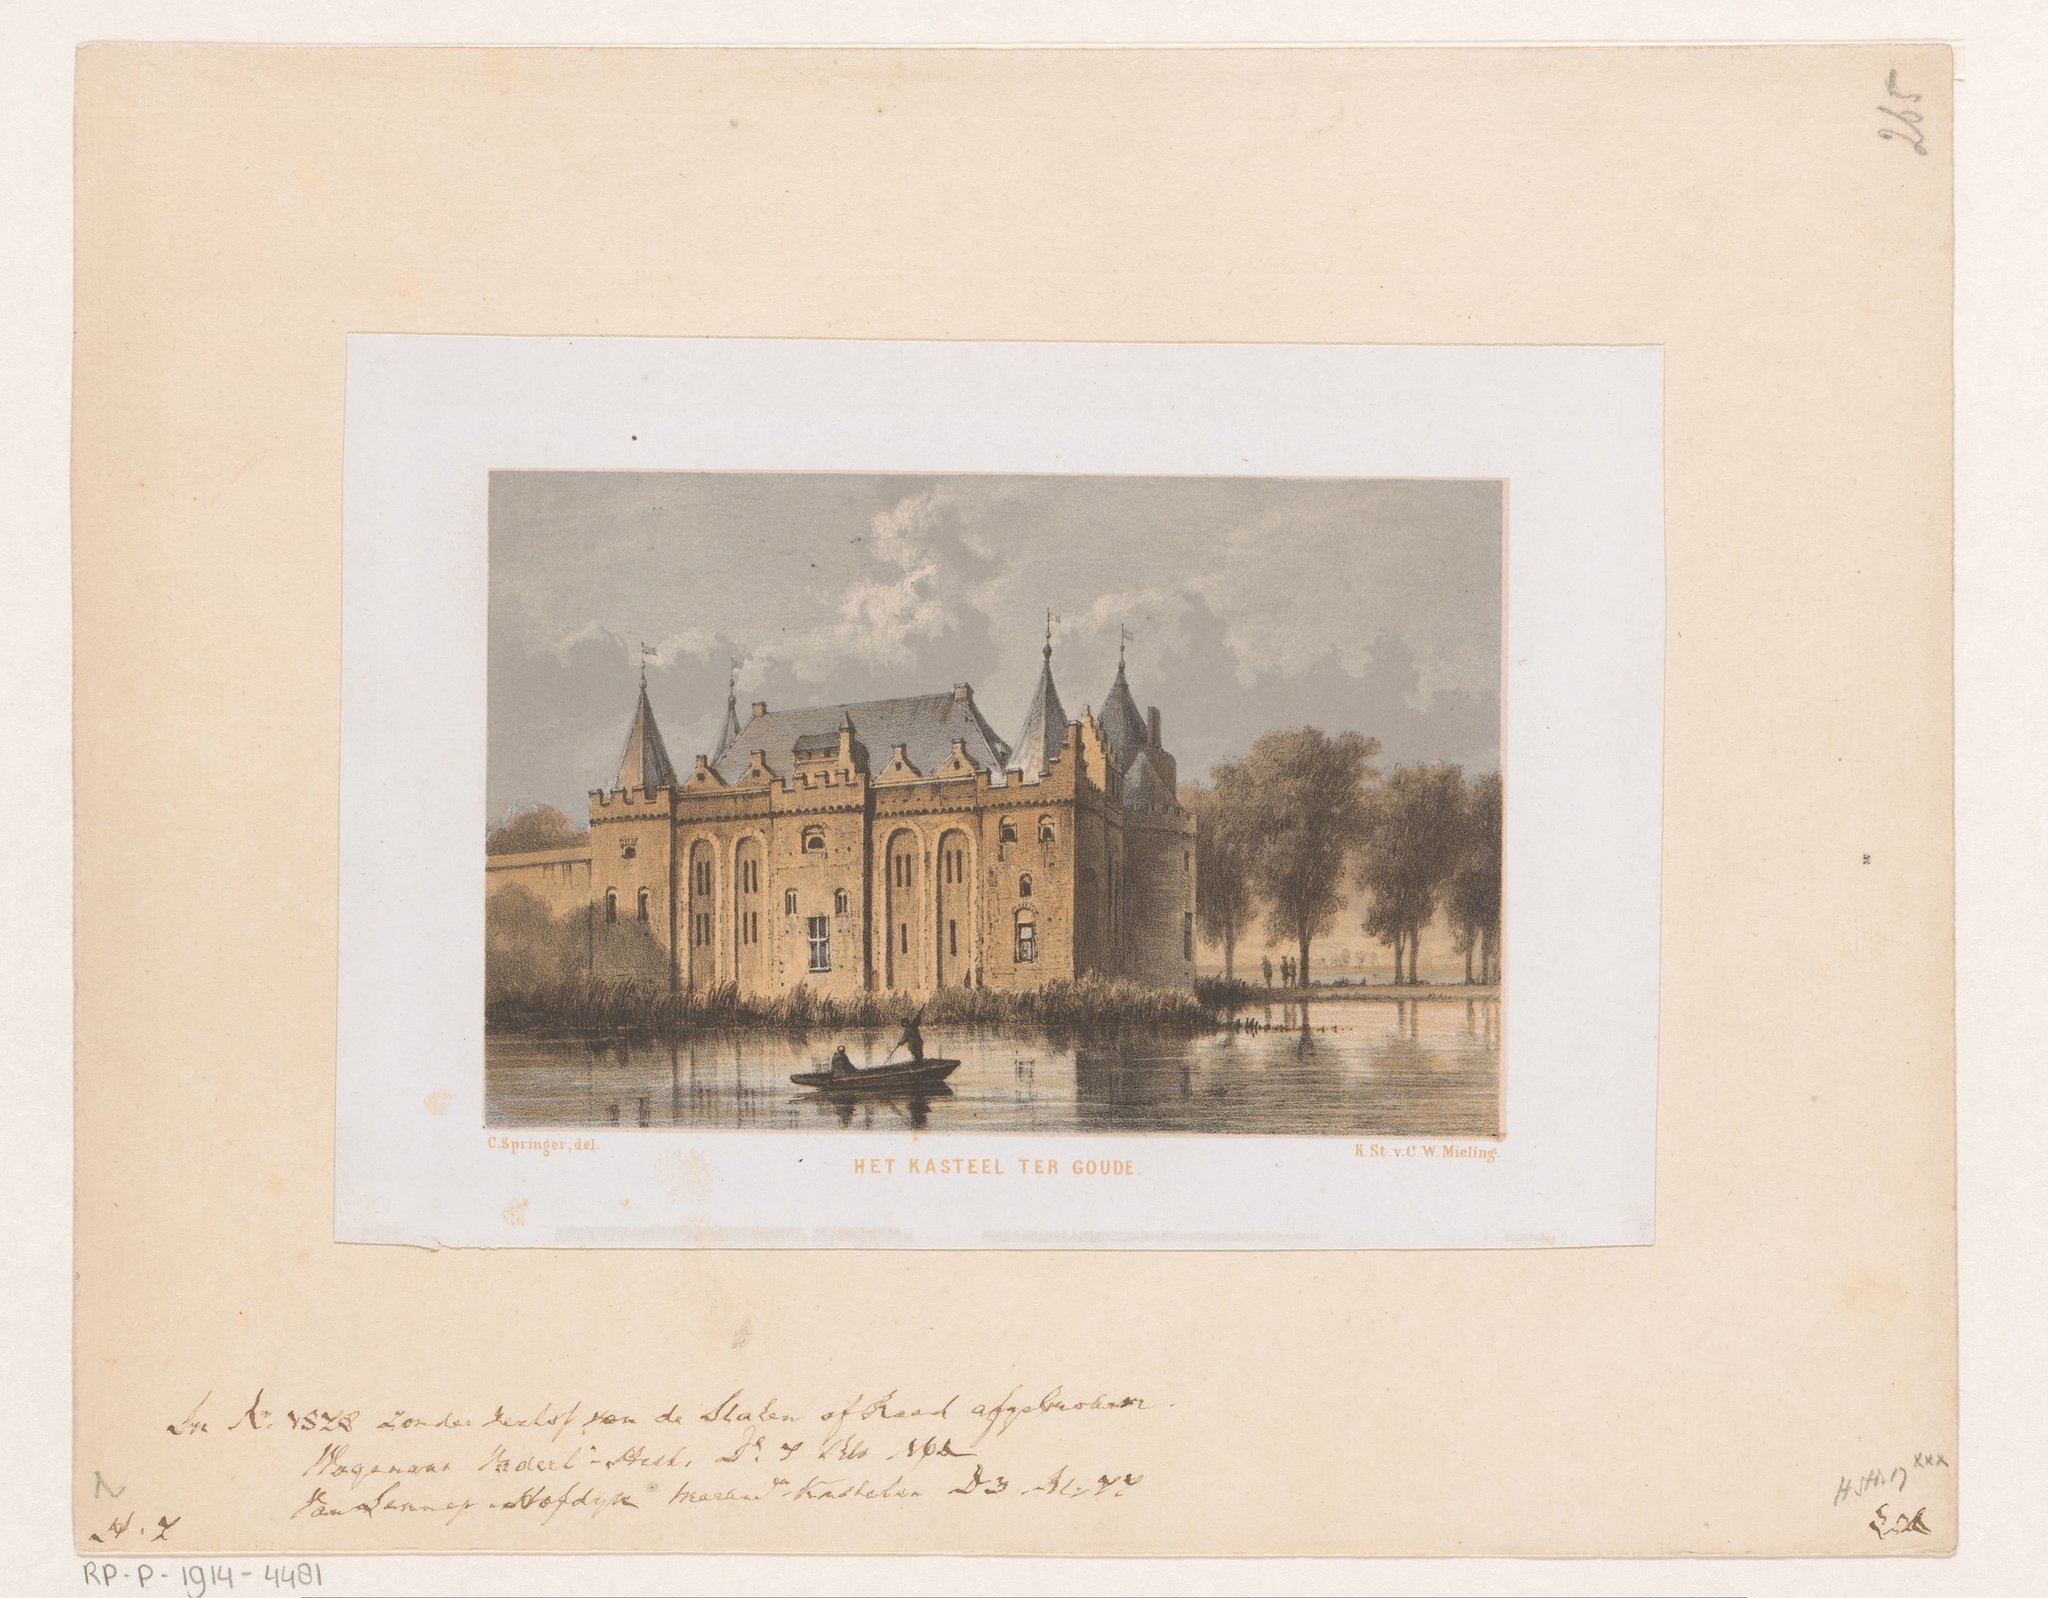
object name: print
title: Het kasteel ter Goude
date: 1847-1865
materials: paper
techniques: tone lithography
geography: the hague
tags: castle, gouda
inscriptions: collector's mark: Lugt 2228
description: Een roeiboot vaart op het water rondom het kasteel van Gouda.